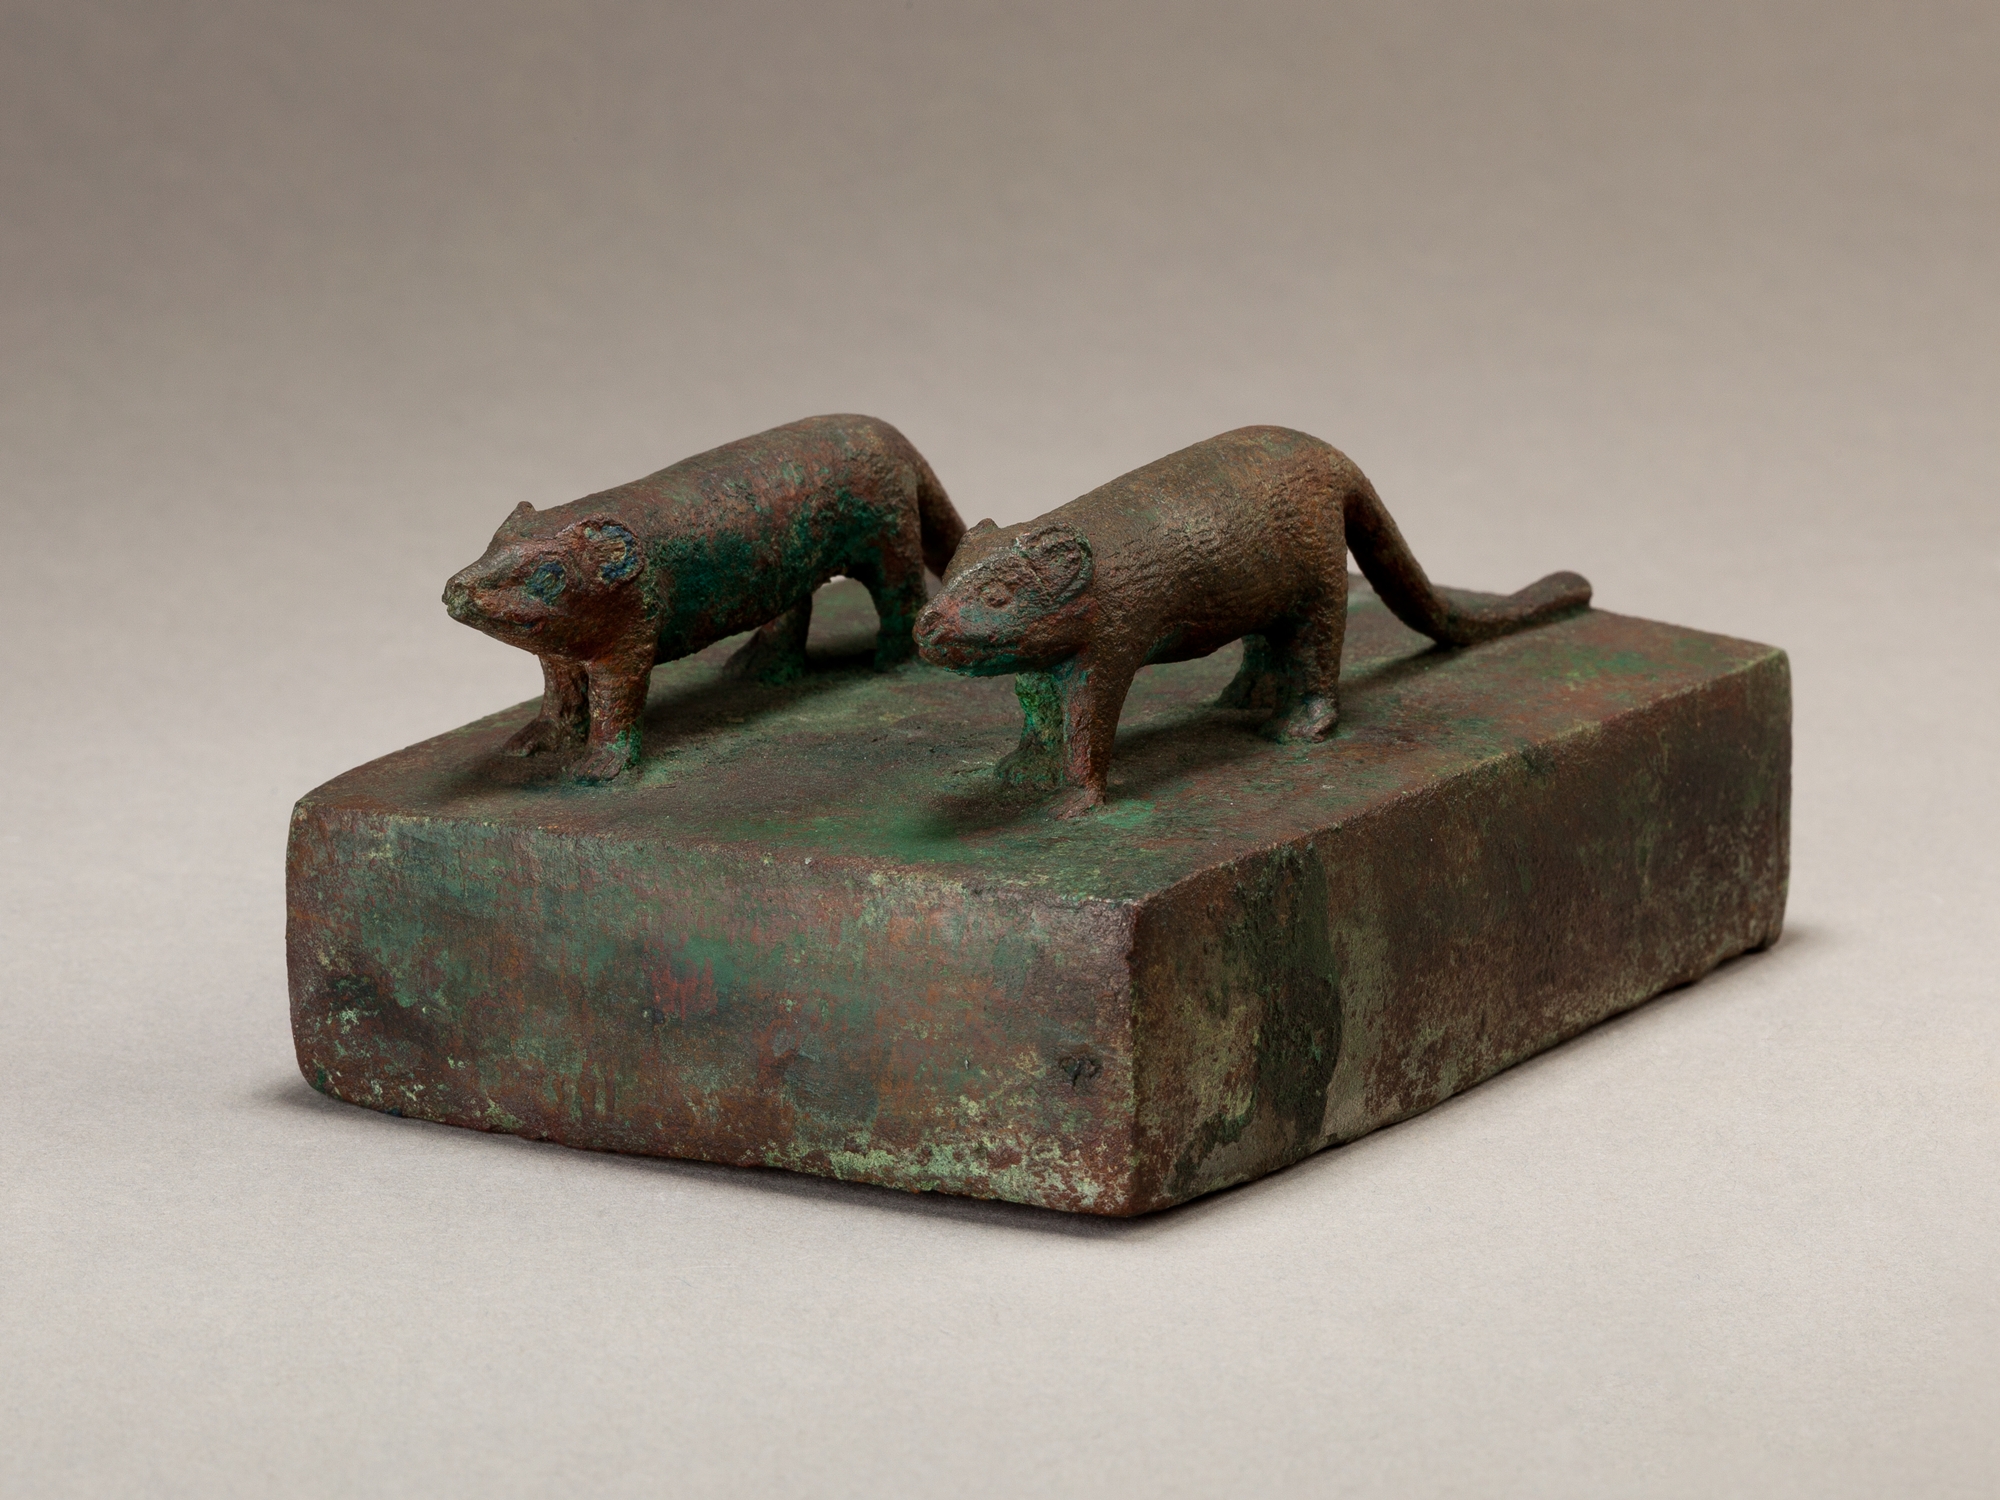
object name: mummy case, ichneumon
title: Two ichneumons surmounting a shrine-shaped box for an animal mummy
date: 664-630 BCE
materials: metal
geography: egypt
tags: animals